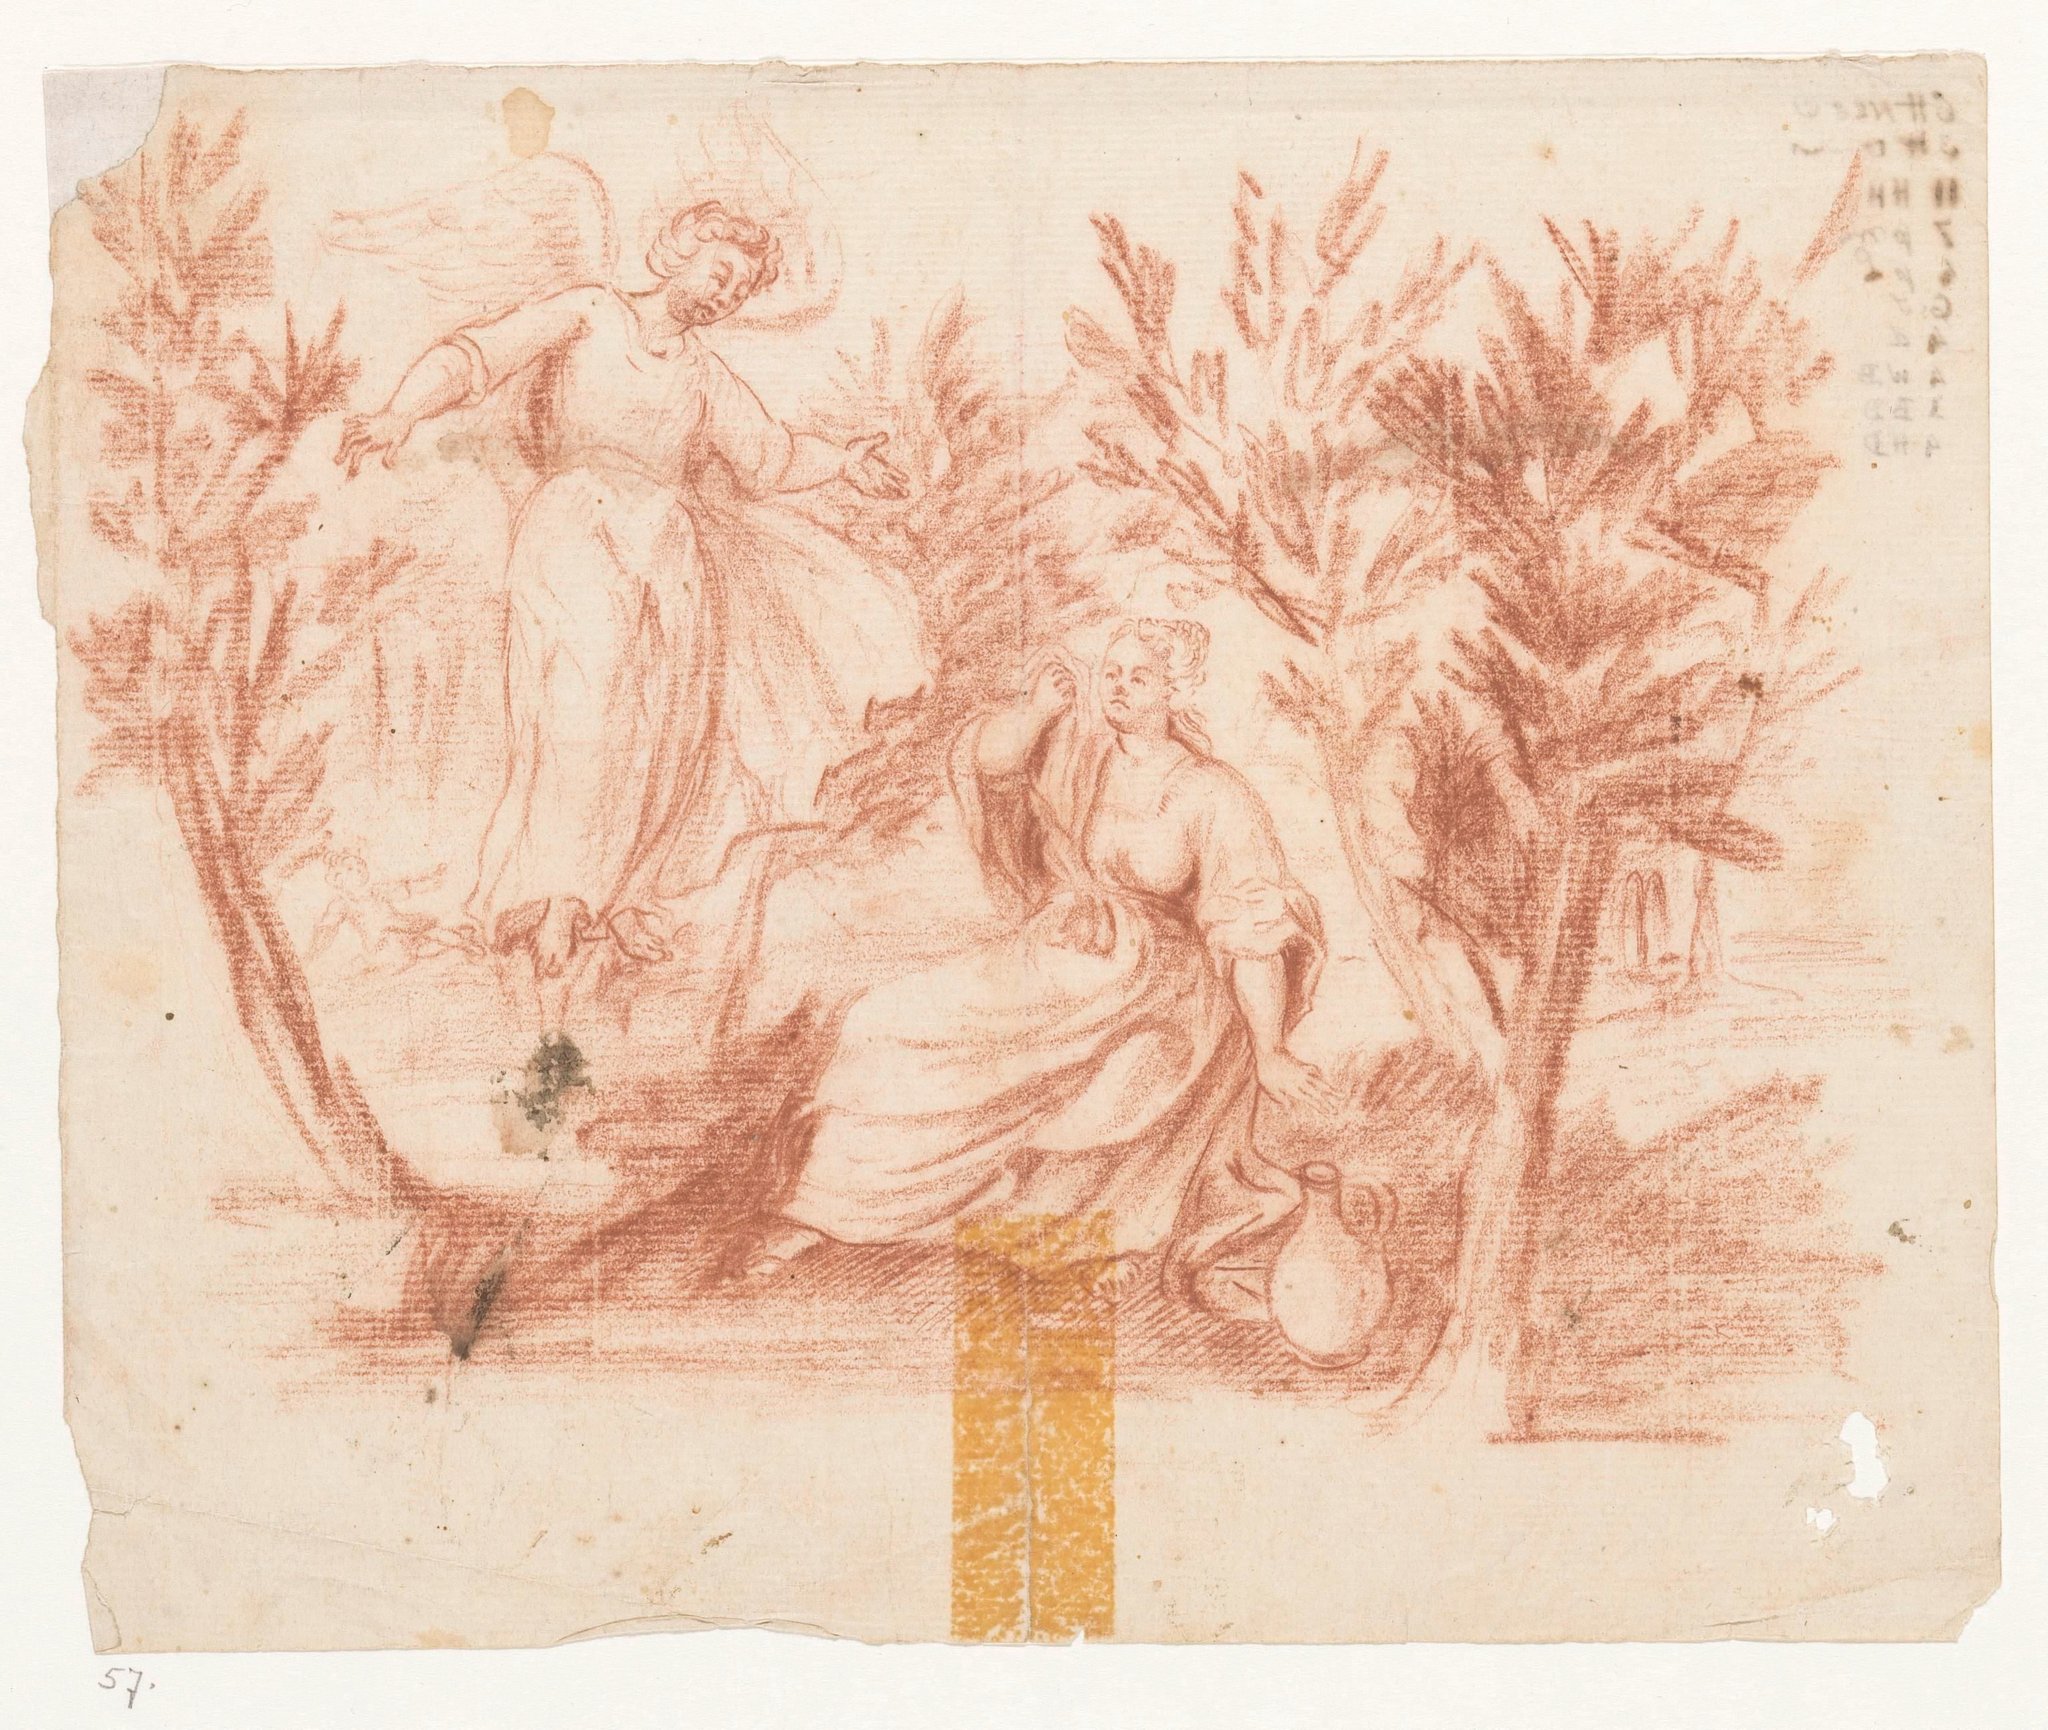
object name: drawing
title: Engel verschijnt aan Hagar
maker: jan brandes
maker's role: draughtsman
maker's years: 1743-1808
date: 1770-1787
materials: chalk, paper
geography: karlberg palace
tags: an angel appears and reveals a well of water to hagar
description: Nadat Hagar Ismaël onder een struik heeft gelegd verschijnt een engel aan de treurende Hager en wijst haar op een waterbron. Achterkant: psalm of versnummers.